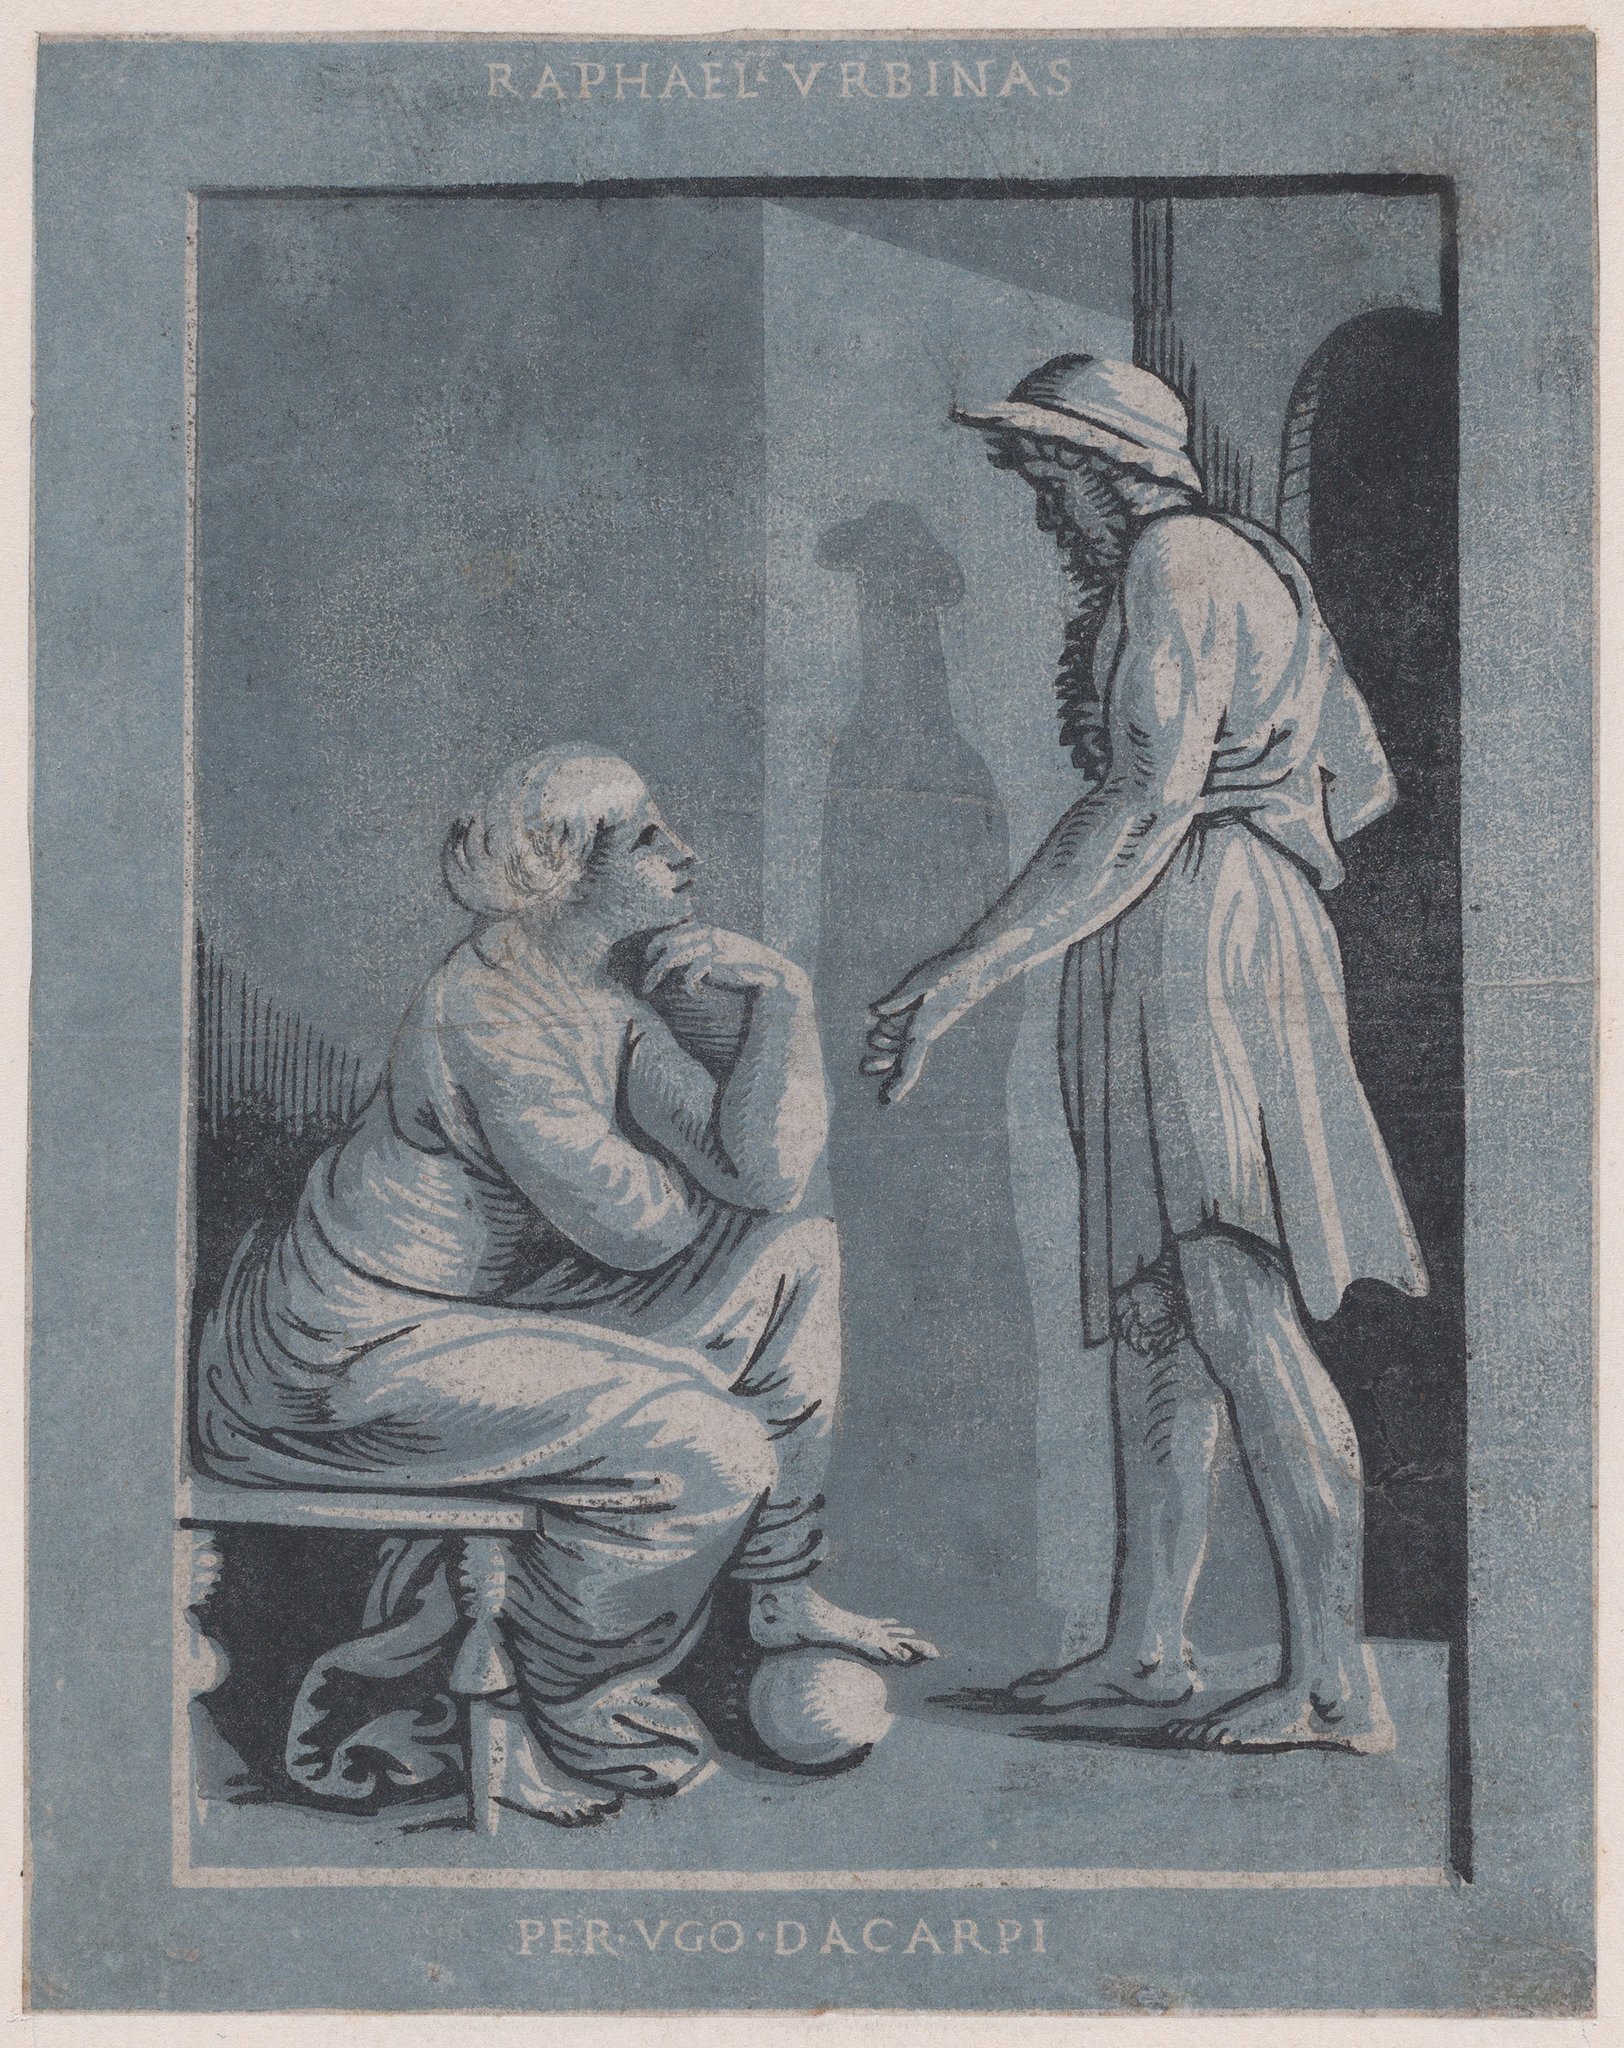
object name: print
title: Penelope and Odysseus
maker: ugo da carpi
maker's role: artist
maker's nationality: italian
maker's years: 1480-1532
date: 1520-1527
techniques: woodcut, printing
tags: men,women